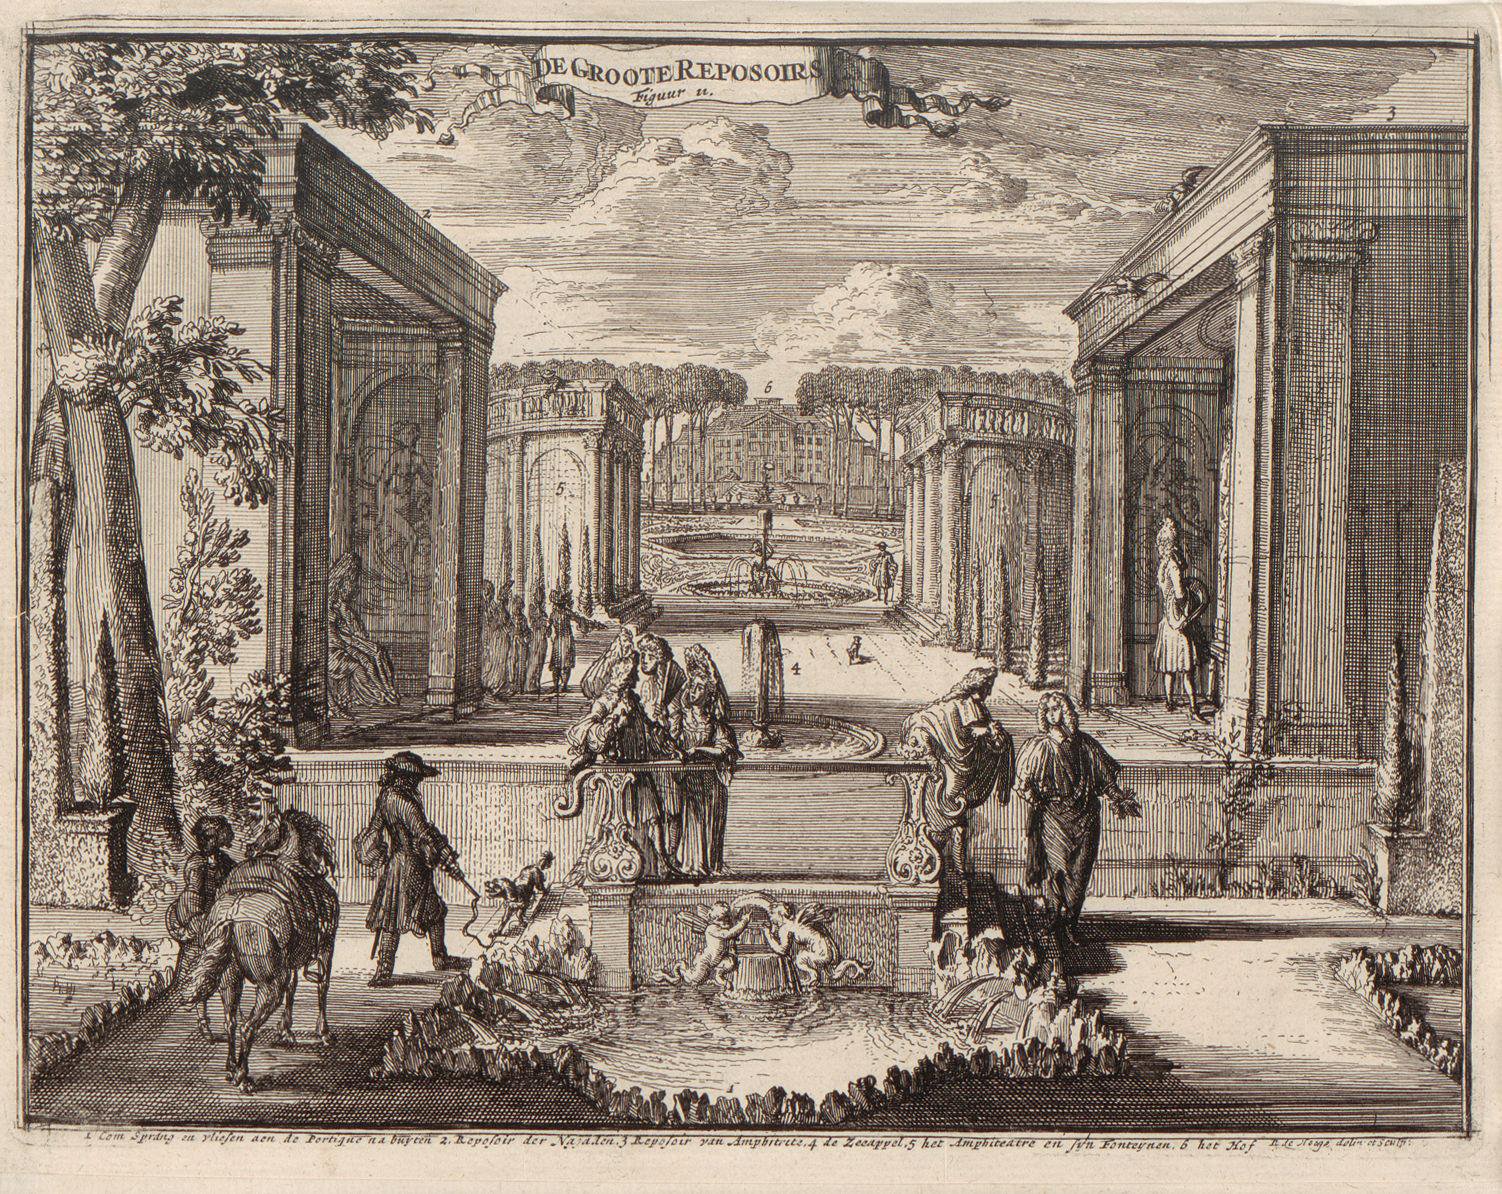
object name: print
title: Gezichten op Paleis Het Loo, de bijbehorende gebouwen en het bijbehorende park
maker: romeyn de hooghe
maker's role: draughtsman, goldsmith, painter, print maker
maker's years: 1645-1708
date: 1690-1694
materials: paper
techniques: etching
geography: haarlem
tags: the hague, william iii (prince of orange and king of england, scotland, and ireland), garden, garden fountain, palace, garden buildings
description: Gezicht op enkele fonteinen en klassieke gebouwtjes in het park van Paleis Het Loo. Rond de fonteinen voorname wandelaars. In de marge onder de voorstelling een legenda in het Nederlands. Dit blad maakt deel uit van een omvangrijke prent met een gezicht op Paleis Het Loo, omgeven door dertien gezichten op de bijbehorende gebouwen en het bijbehorende park (boven, links, rechts), en een profiel van het paleis (onder).